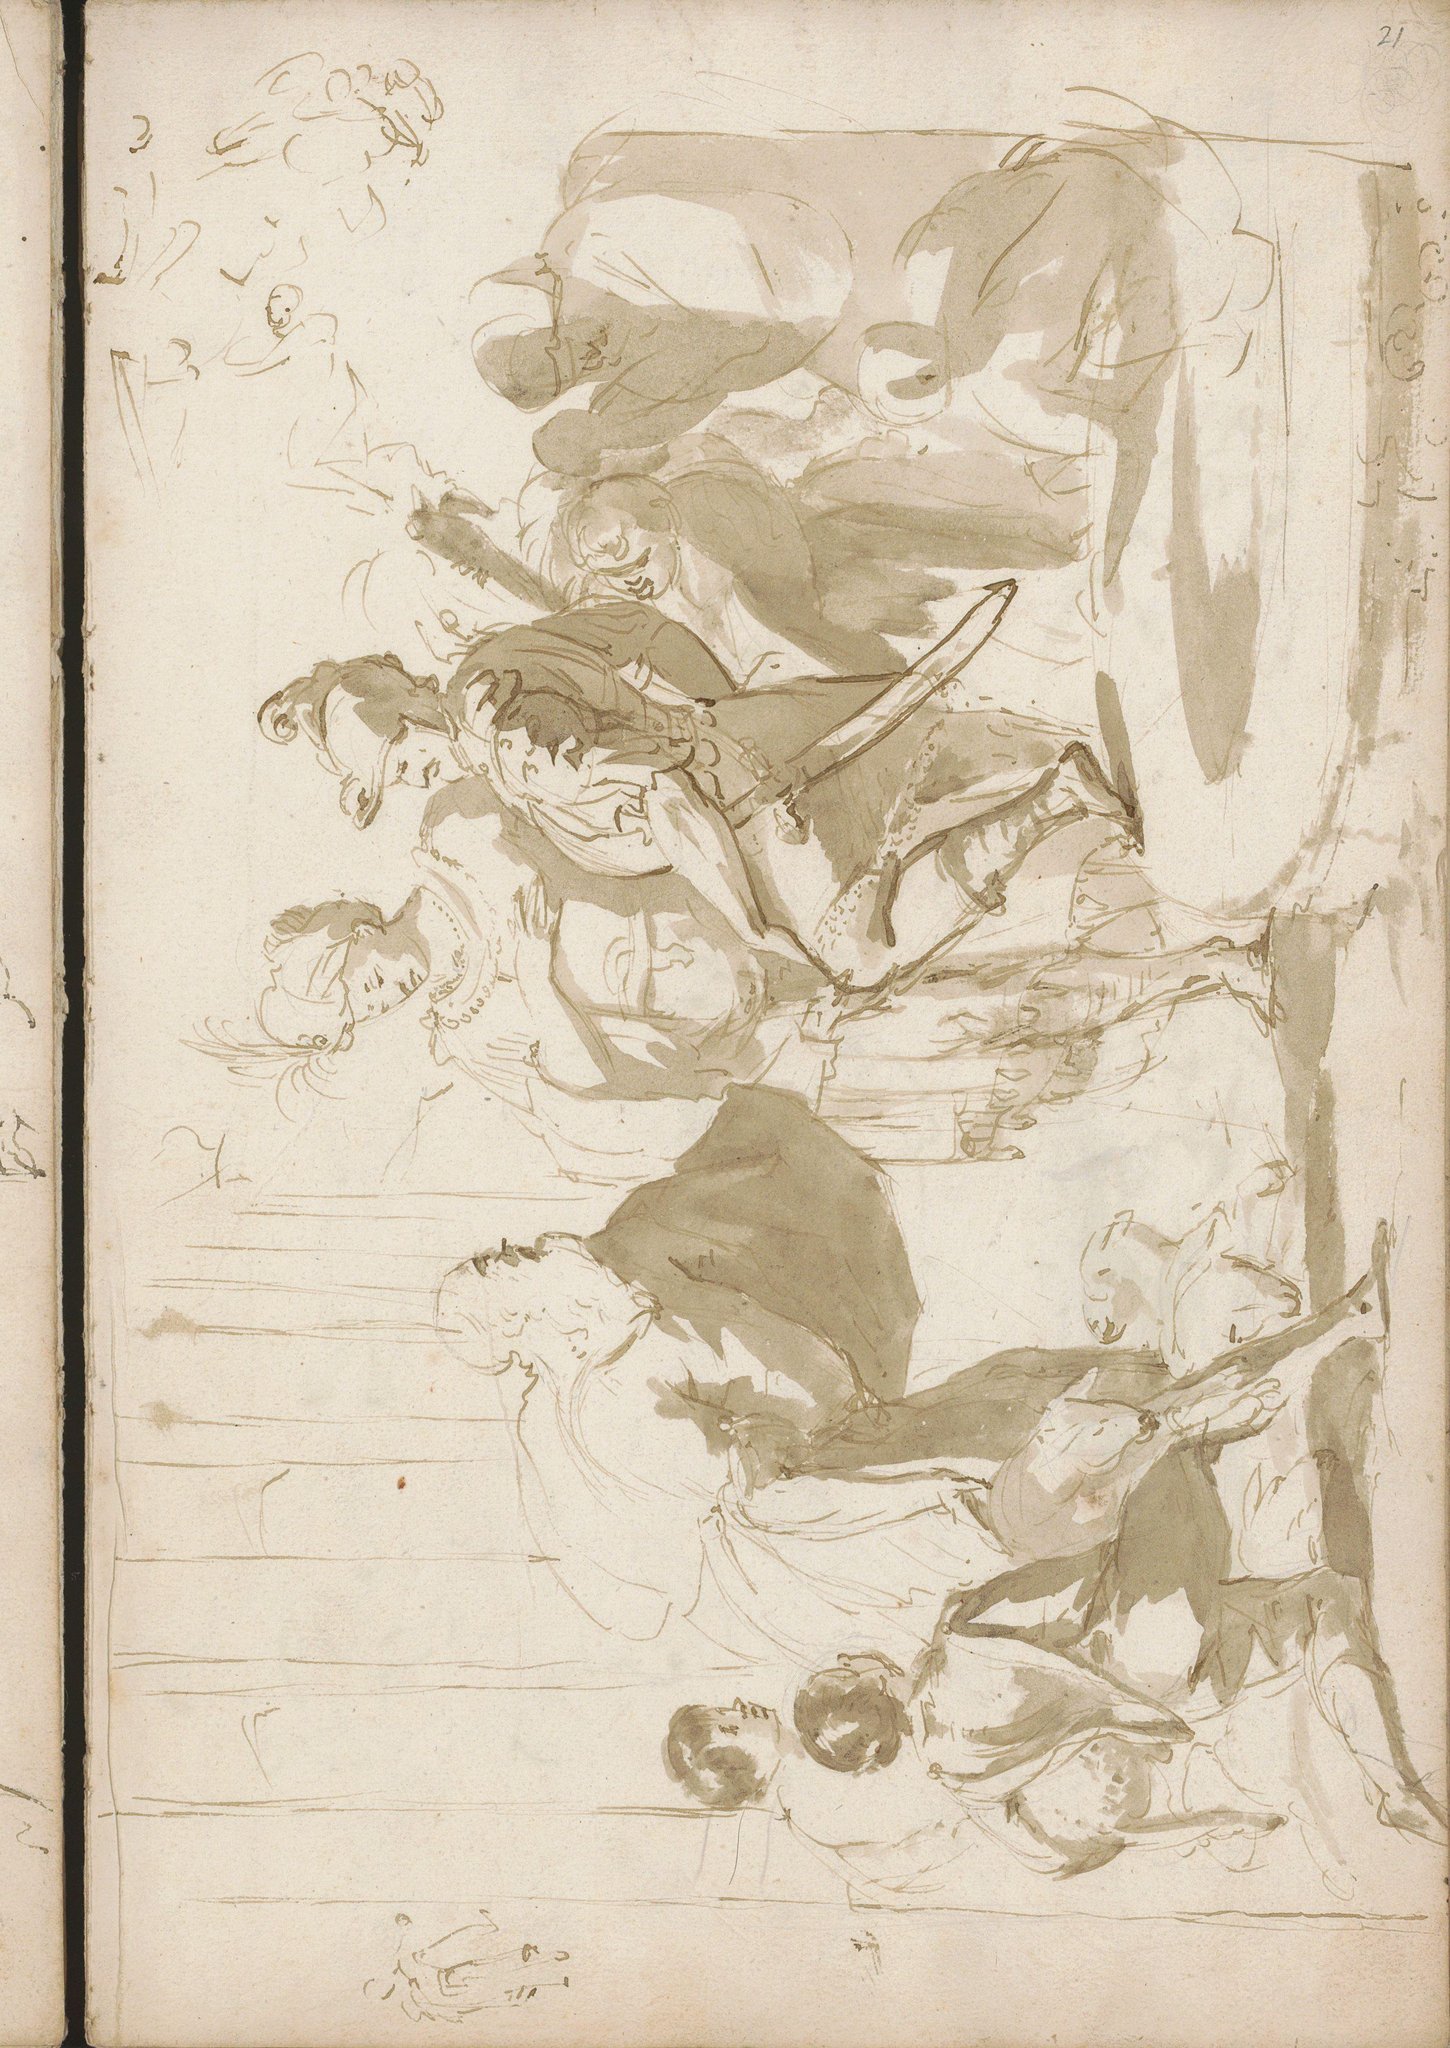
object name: sketchbook leaf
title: Man die twee lammeren aanbiedt aan een Romeins militair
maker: Anonymous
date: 1650-1799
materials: ink, paper, pencil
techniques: brush, pen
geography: italy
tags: lamb, kneeling figure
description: Een man met baard buigt zich voorover en raakt met zijn linkerhand de knie van de Romeinse soldaat. Met zijn rechterhand wijst hij op een lam, gedragen door een jongen. Op de grond ligt een tweede lam. Naast de soldaat staat een man met tulband die zijn hand op de borst houdt en de man en lammeren gadeslaat. Bladzijde 21 uit een schetsboek met 72 bladzijden.